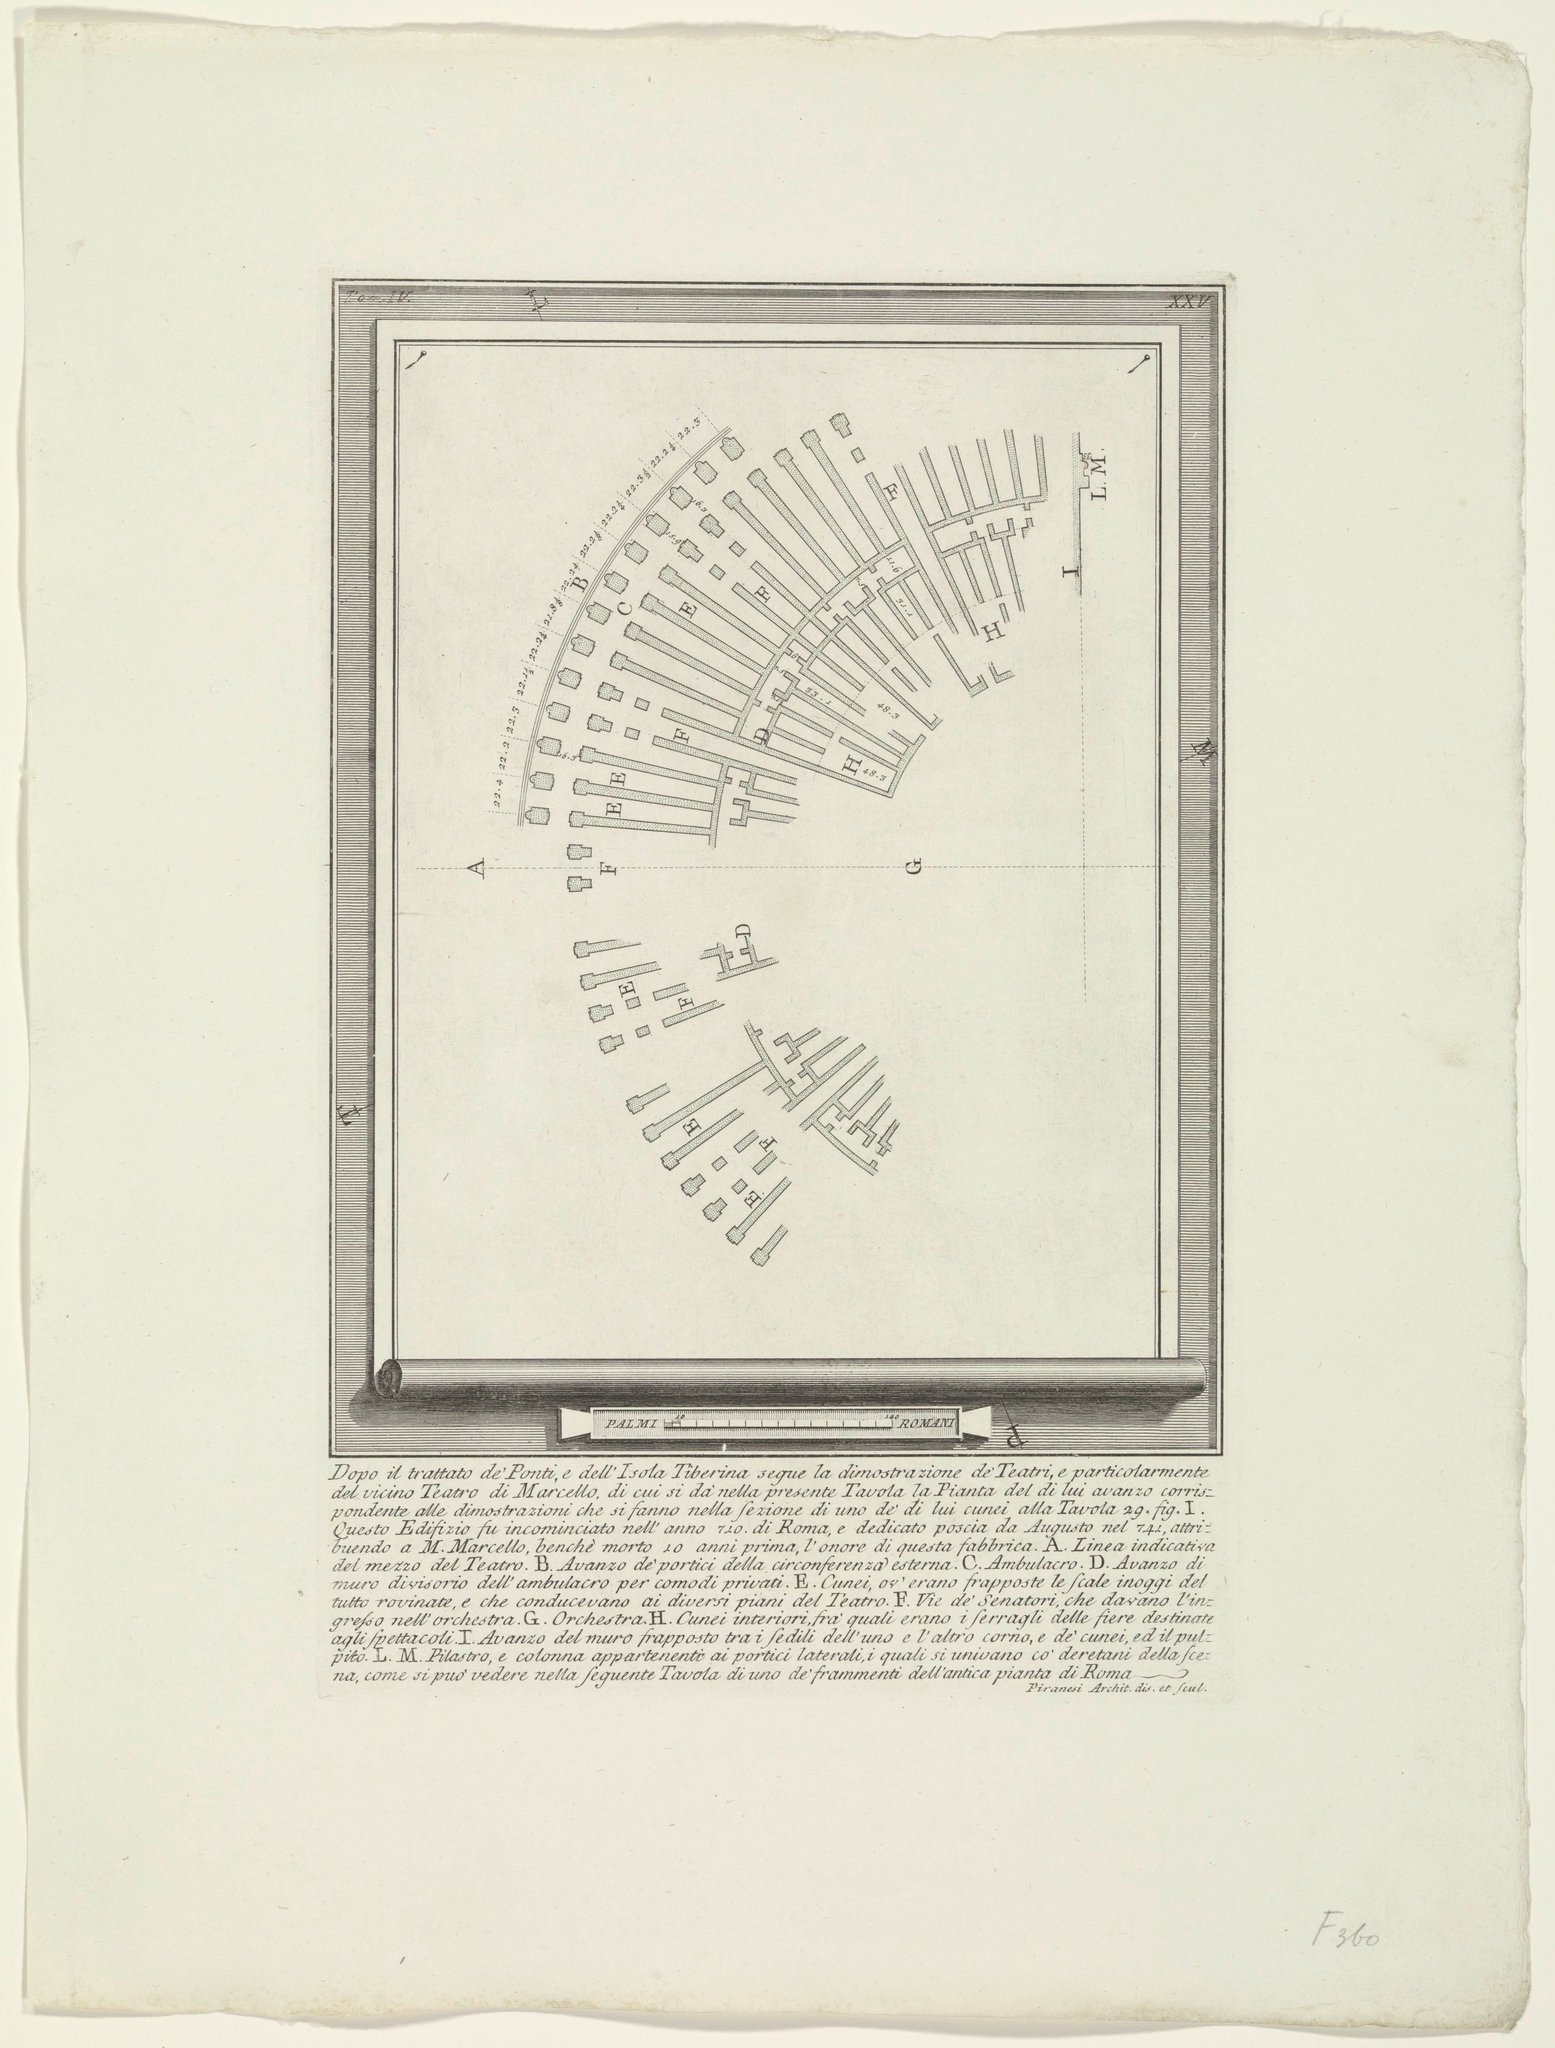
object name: print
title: Plattegrond van het Theater van Marcellus te Rome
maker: giovanni battista piranesi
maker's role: designer, draughtsman, print maker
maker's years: 1720-1778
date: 1756-1757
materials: paper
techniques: etching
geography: rome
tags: ruin of a building ~ architecture, theatre (building), plan ~ architecture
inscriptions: collector's mark: Lugt 2228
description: Deze prent maakt deel uit van de serie 'Le Antichità Romane'. Piranesi deed meer dan acht jaar voorstudie voor deze 250 platen tellende serie die in vier volumes werd uitgegeven. Hij produceerde de prenten tussen ca. 1756 en 1757. De serie bevat ook prenten door of naar andere prentmakers, onder wie Francesco Bianchini en Girolamo Rossi.